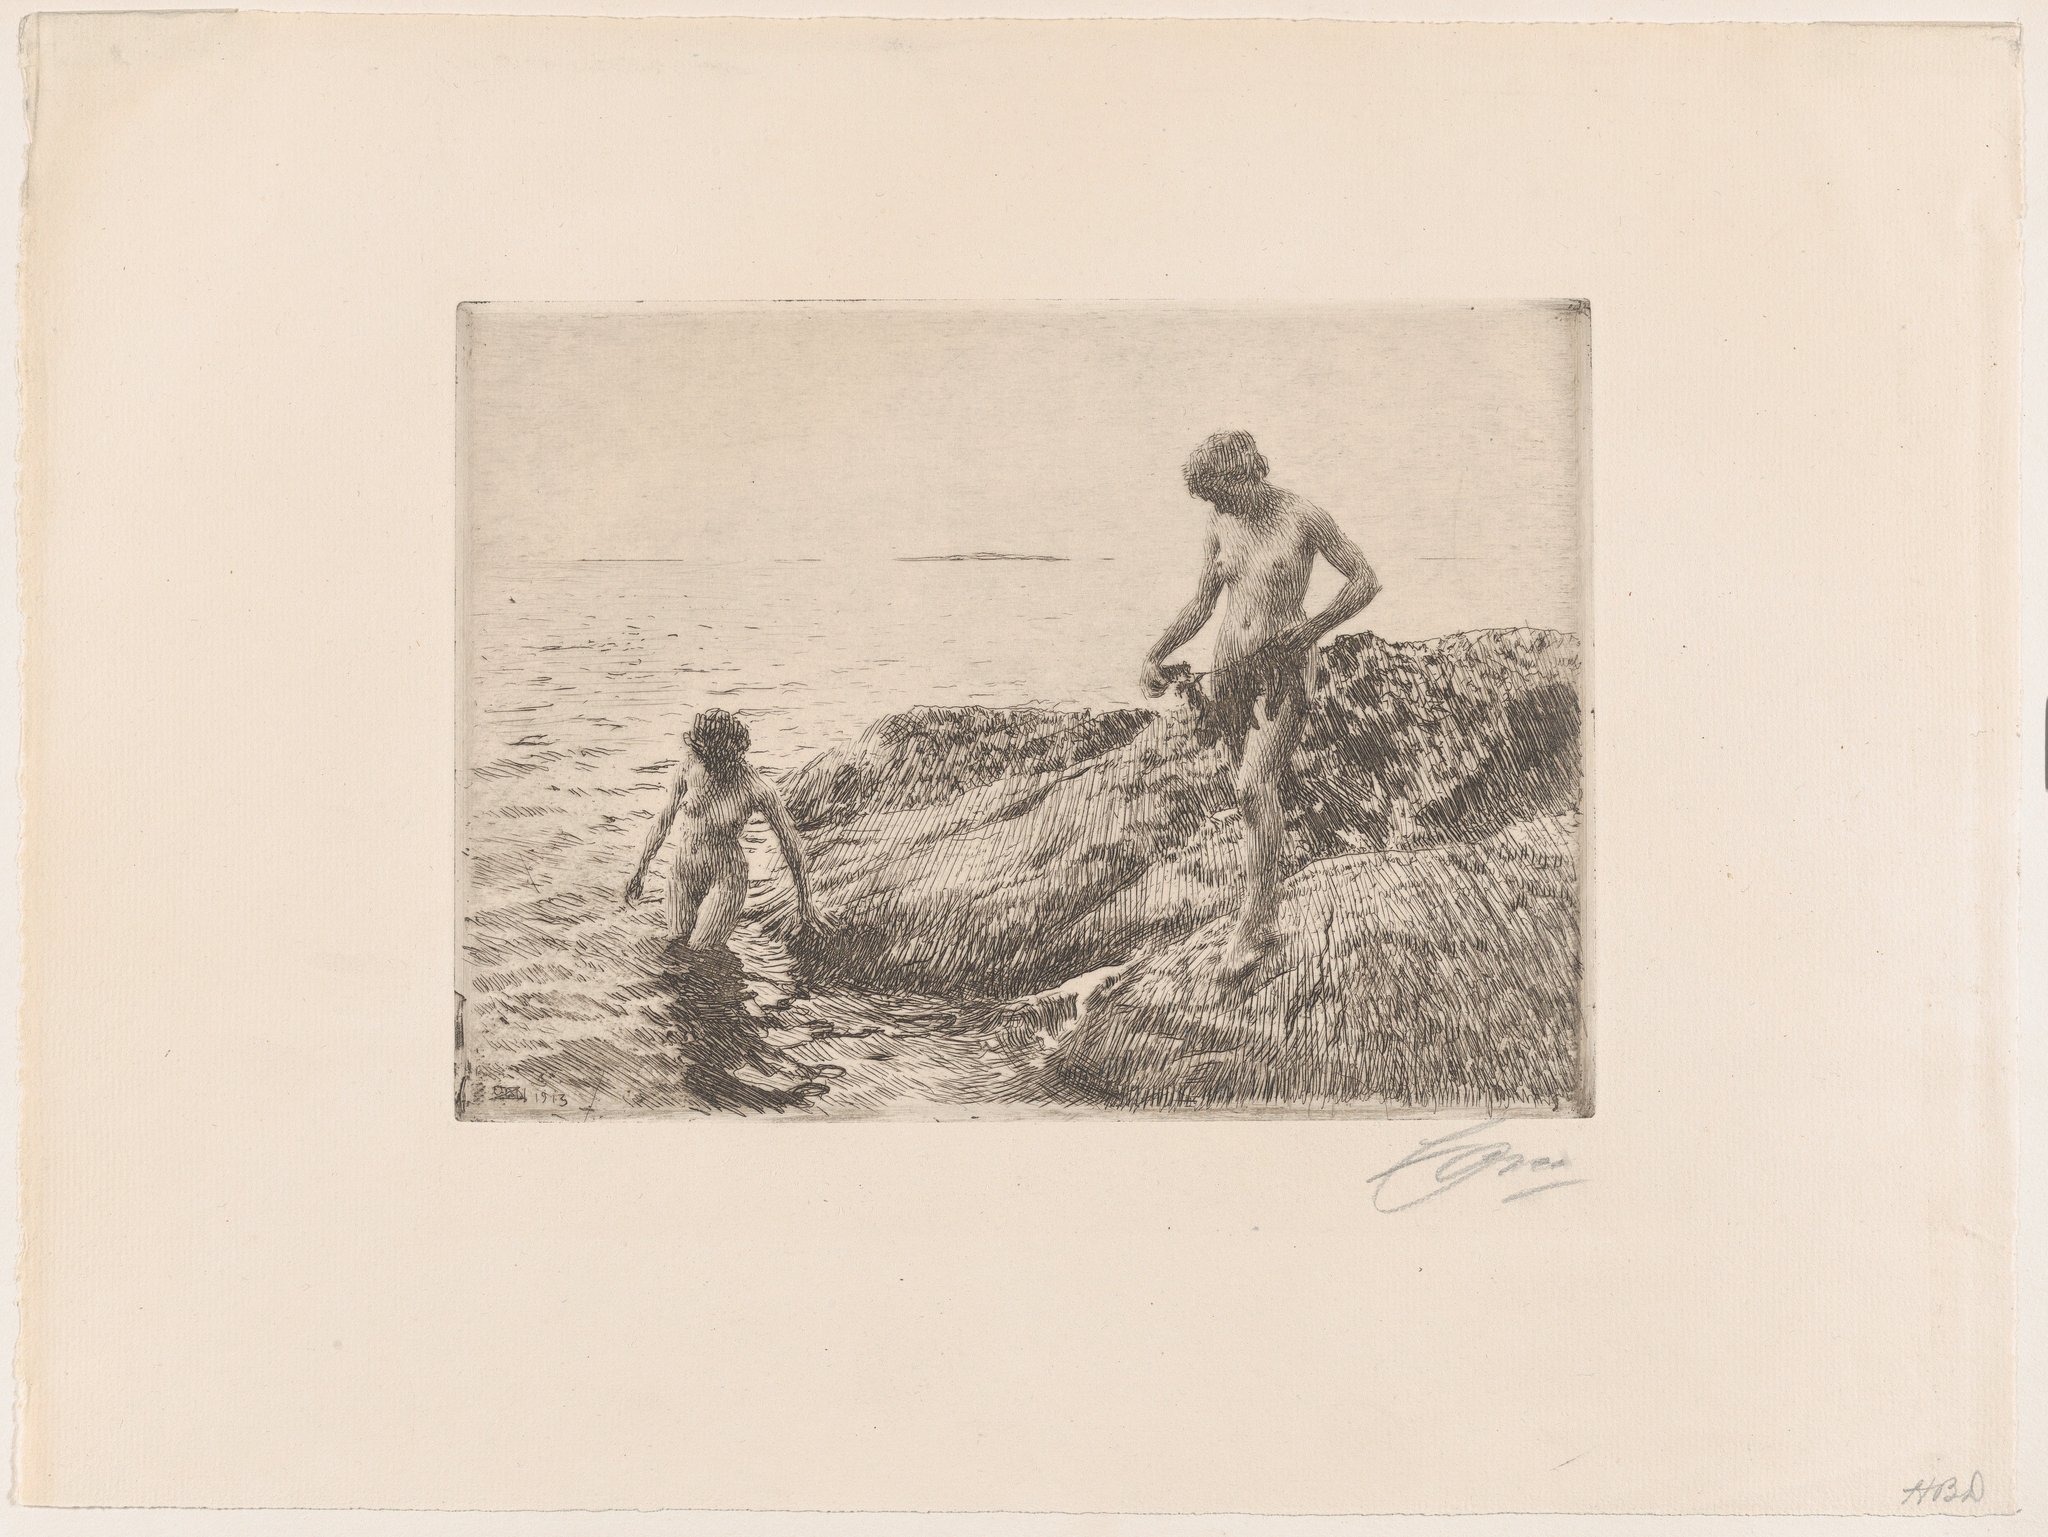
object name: print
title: Seaward Skerries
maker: anders zorn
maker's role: artist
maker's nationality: swedish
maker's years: 1860-1920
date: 1913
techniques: etching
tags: female nudes,bathing